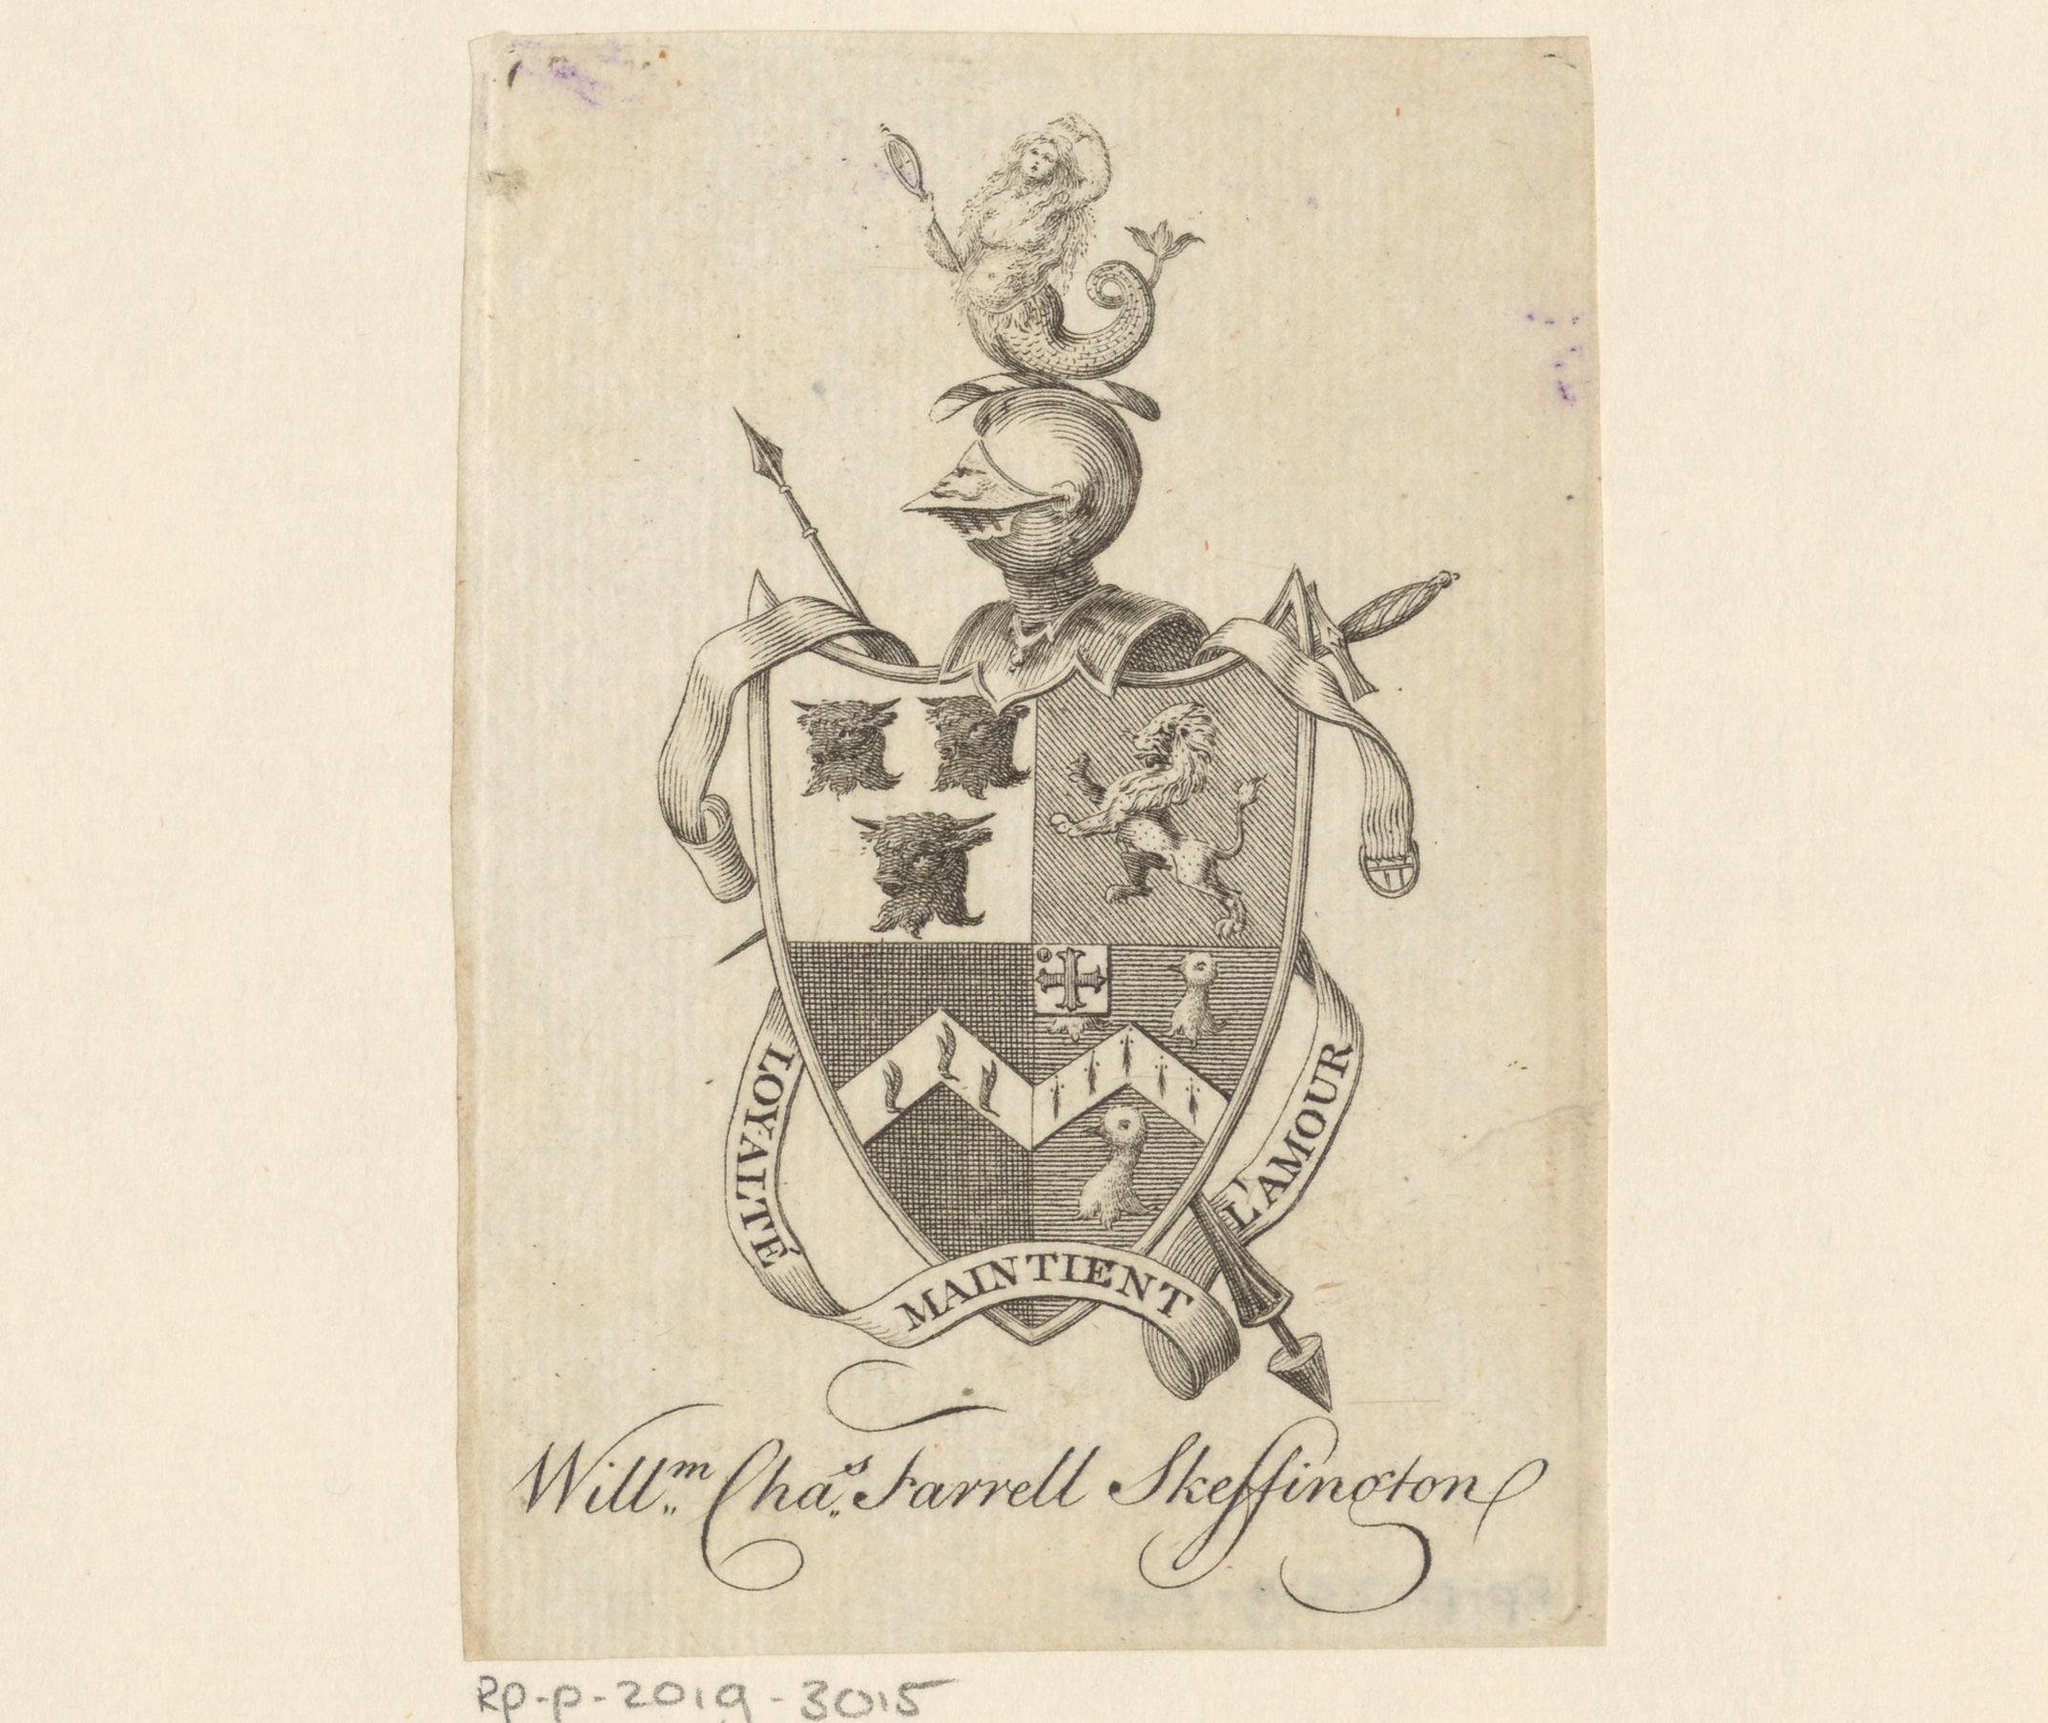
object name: bookplate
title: Ex libris van Willm. Chas. Farrell Skeffington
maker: mussett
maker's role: print maker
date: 1752-1815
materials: paper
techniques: engraving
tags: armorial bearing, heraldry